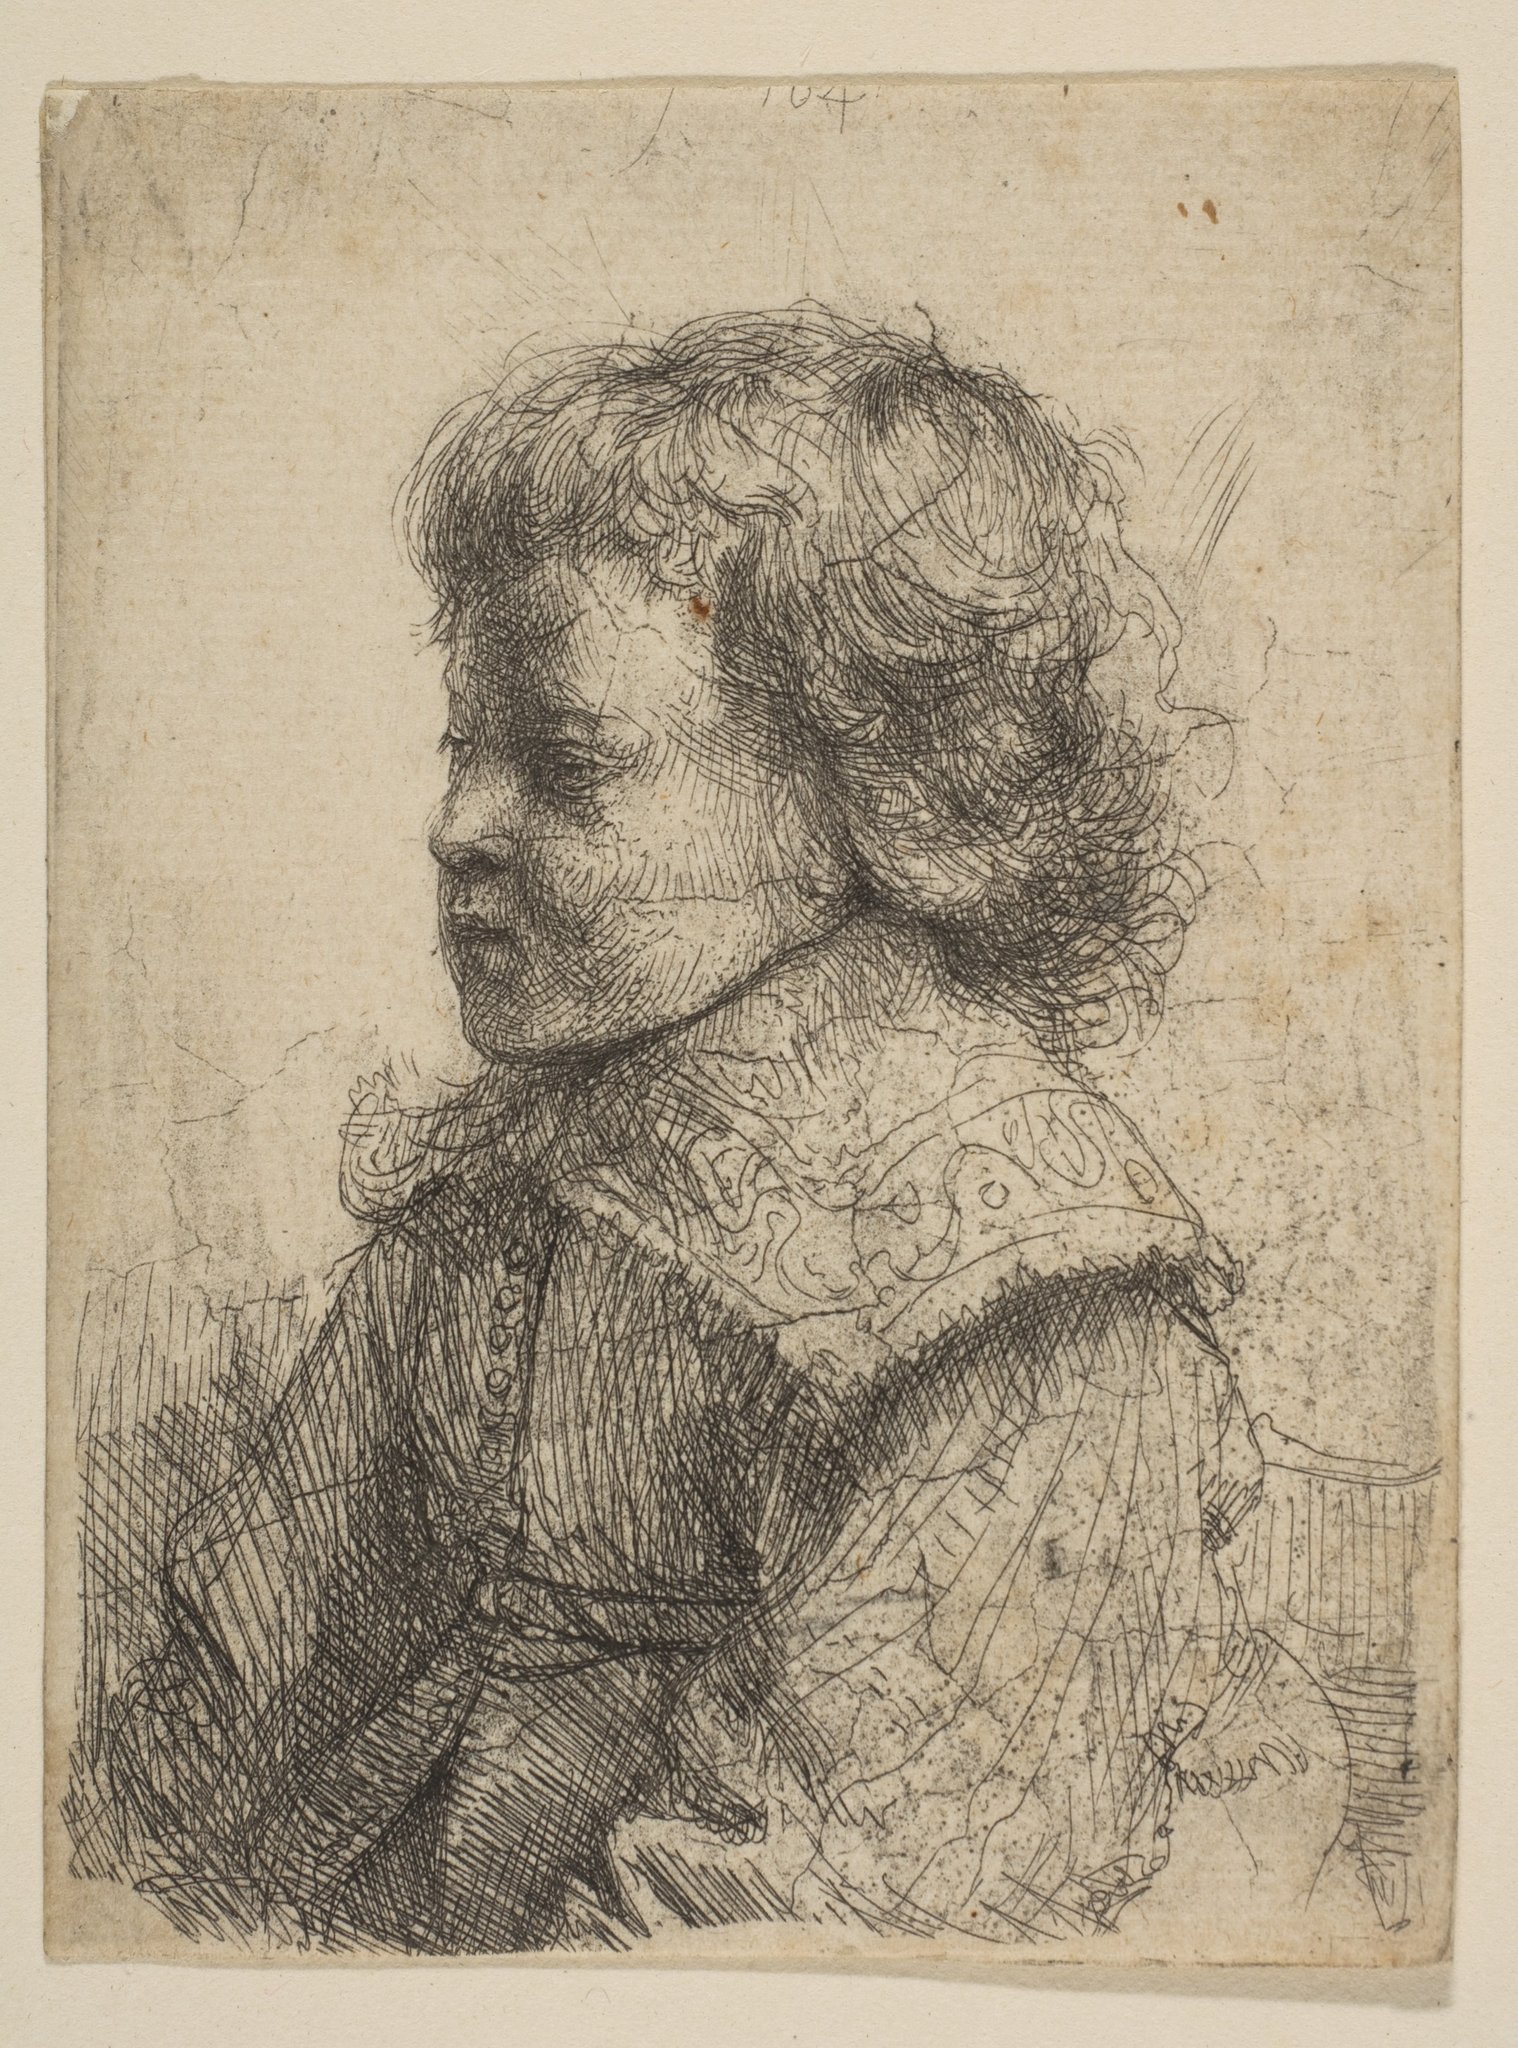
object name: print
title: Portrait of a Boy, in Profile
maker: rembrandt van rijn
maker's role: artist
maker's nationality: dutch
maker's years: 1606-1669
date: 1641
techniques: etching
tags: boys